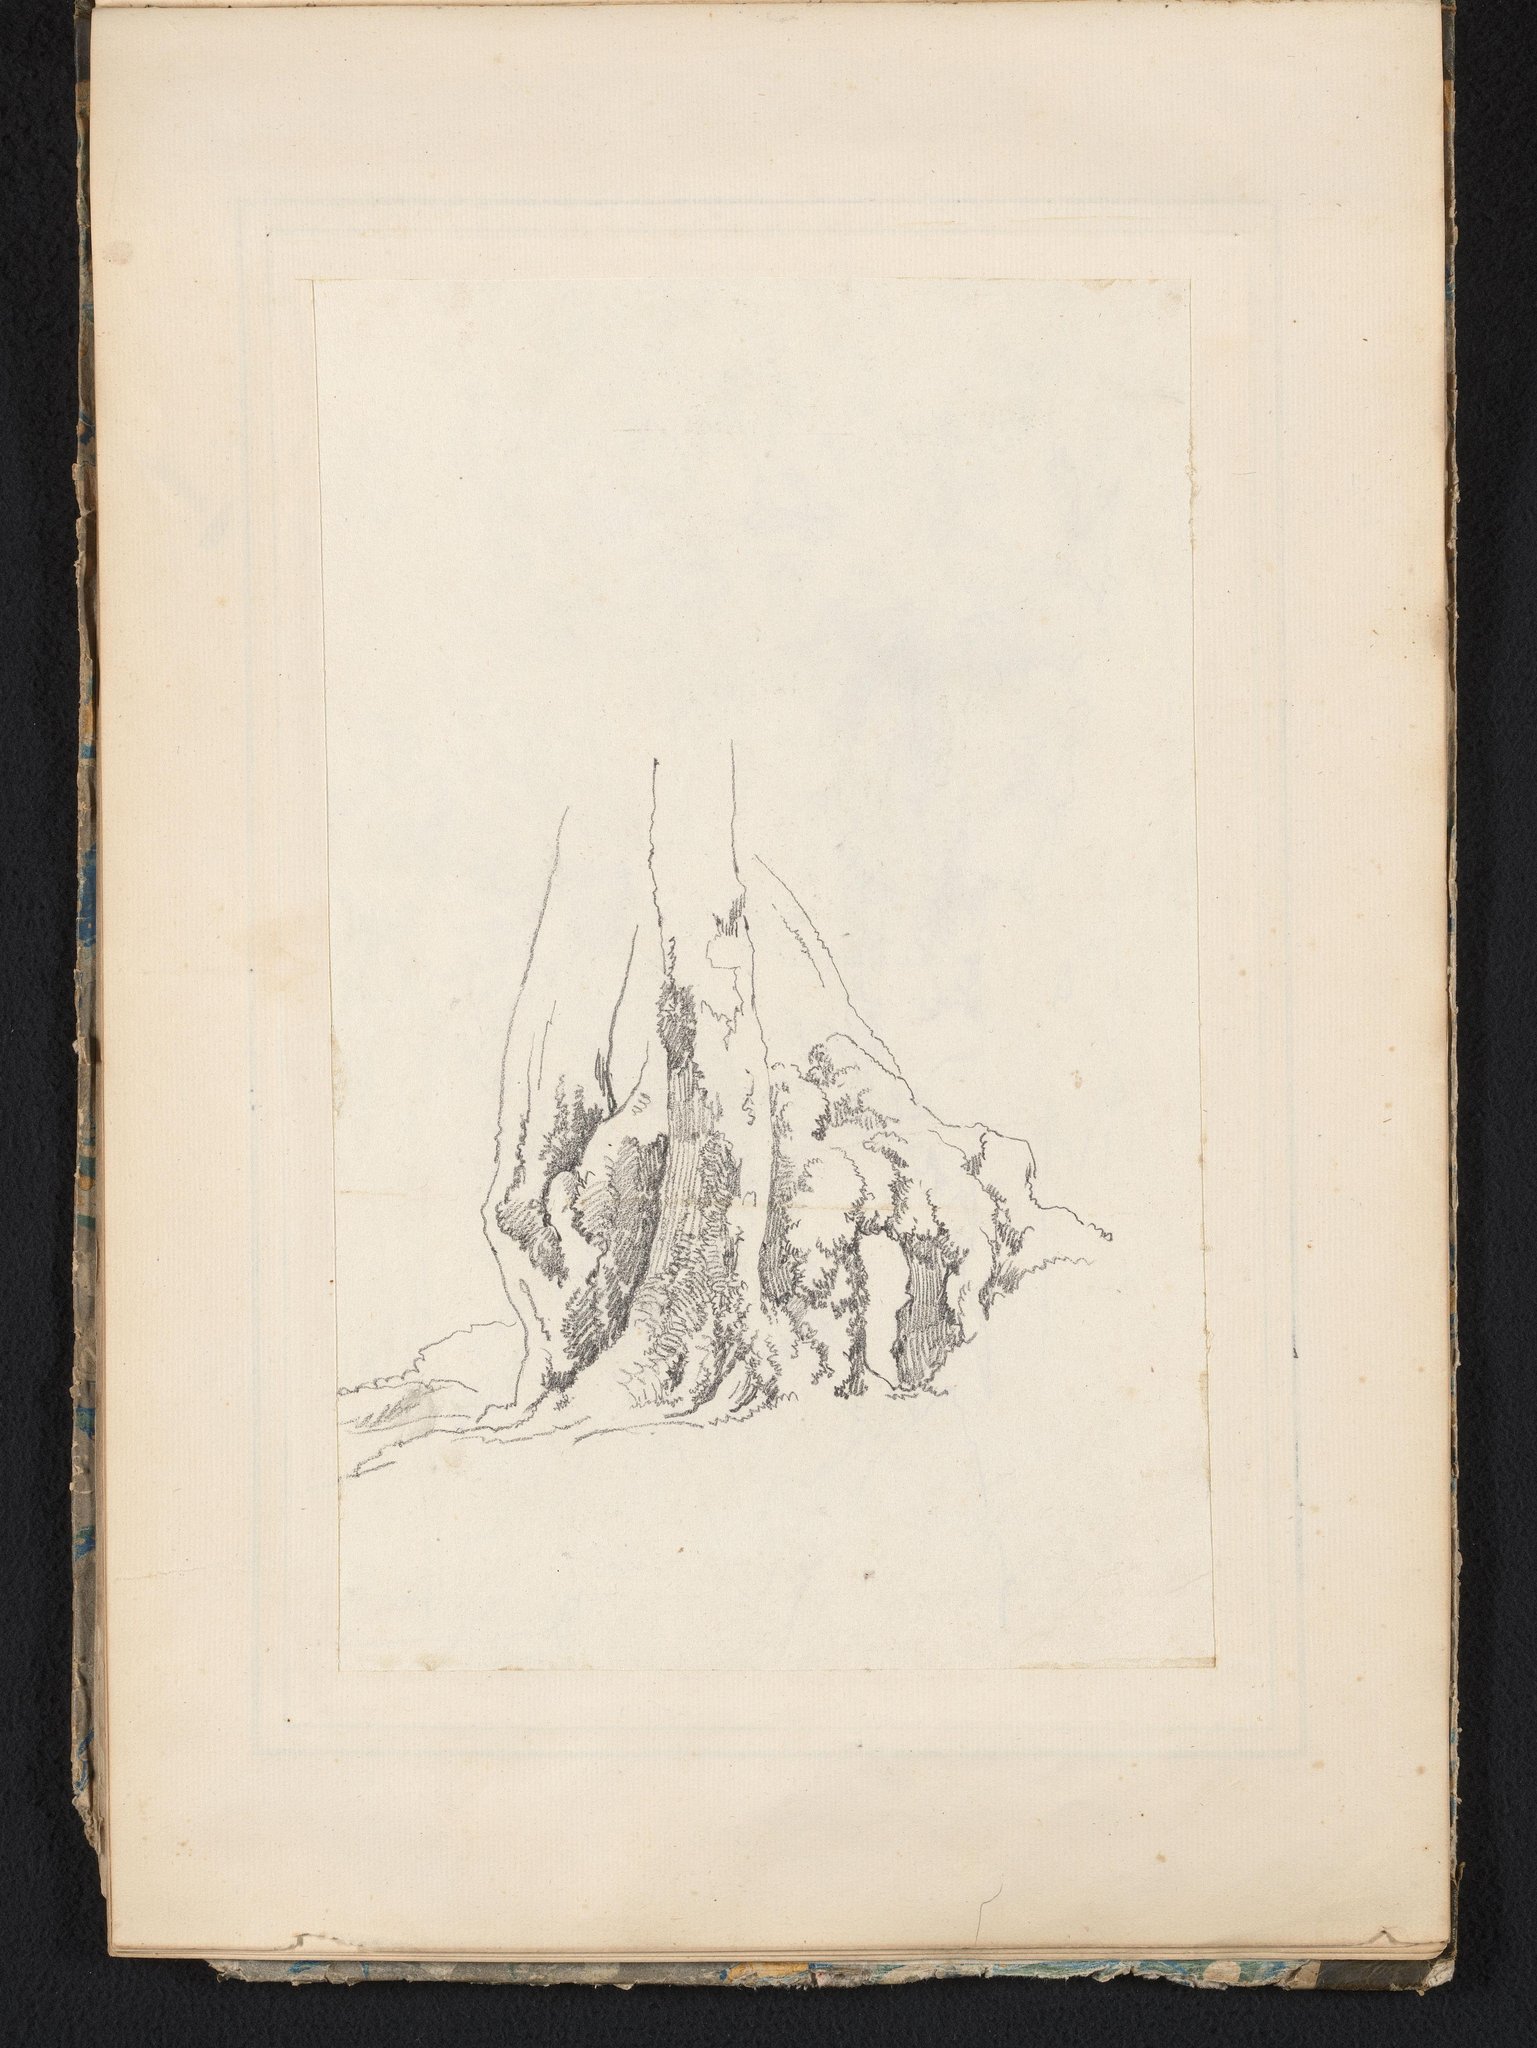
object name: drawing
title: Boom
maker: hendrik voogd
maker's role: draughtsman, painter, print maker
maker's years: 1768-1839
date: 1788-1839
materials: paper, pencil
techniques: pasting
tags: trees, landscapes, italy